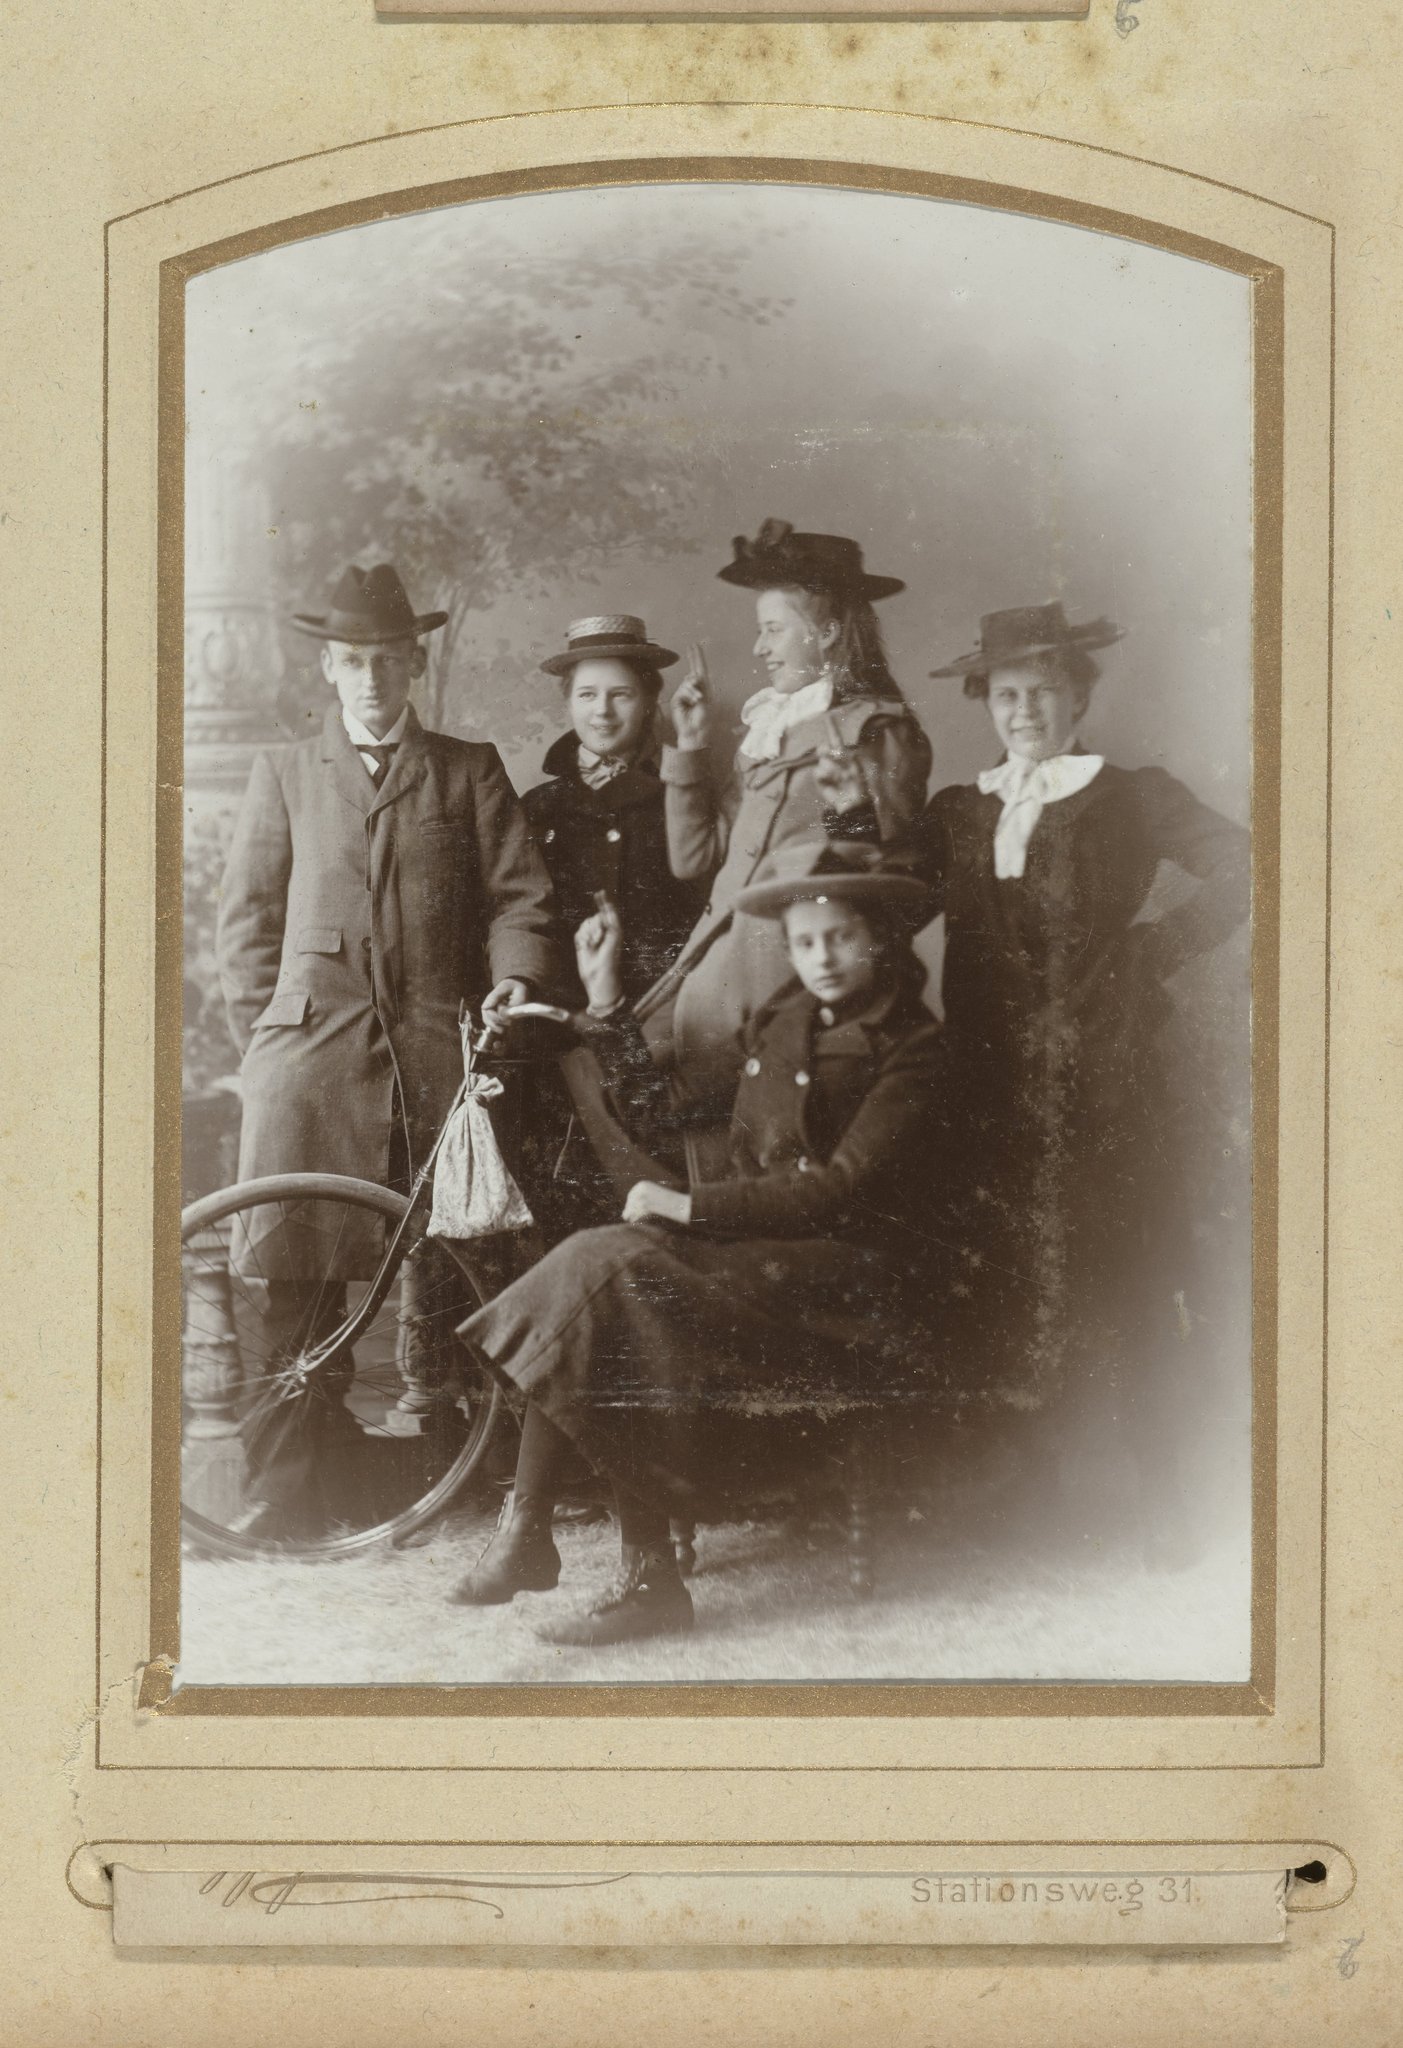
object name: carte de visite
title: Groeportret ter herinnering van ONZGN fietstocht op 1 april 1902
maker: eugène jean joseph groeneveld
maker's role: fotograaf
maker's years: 1866-1940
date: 1890-1910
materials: paper, photographic support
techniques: photography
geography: leiden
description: Vier vrouwen en een man staan om een fiets